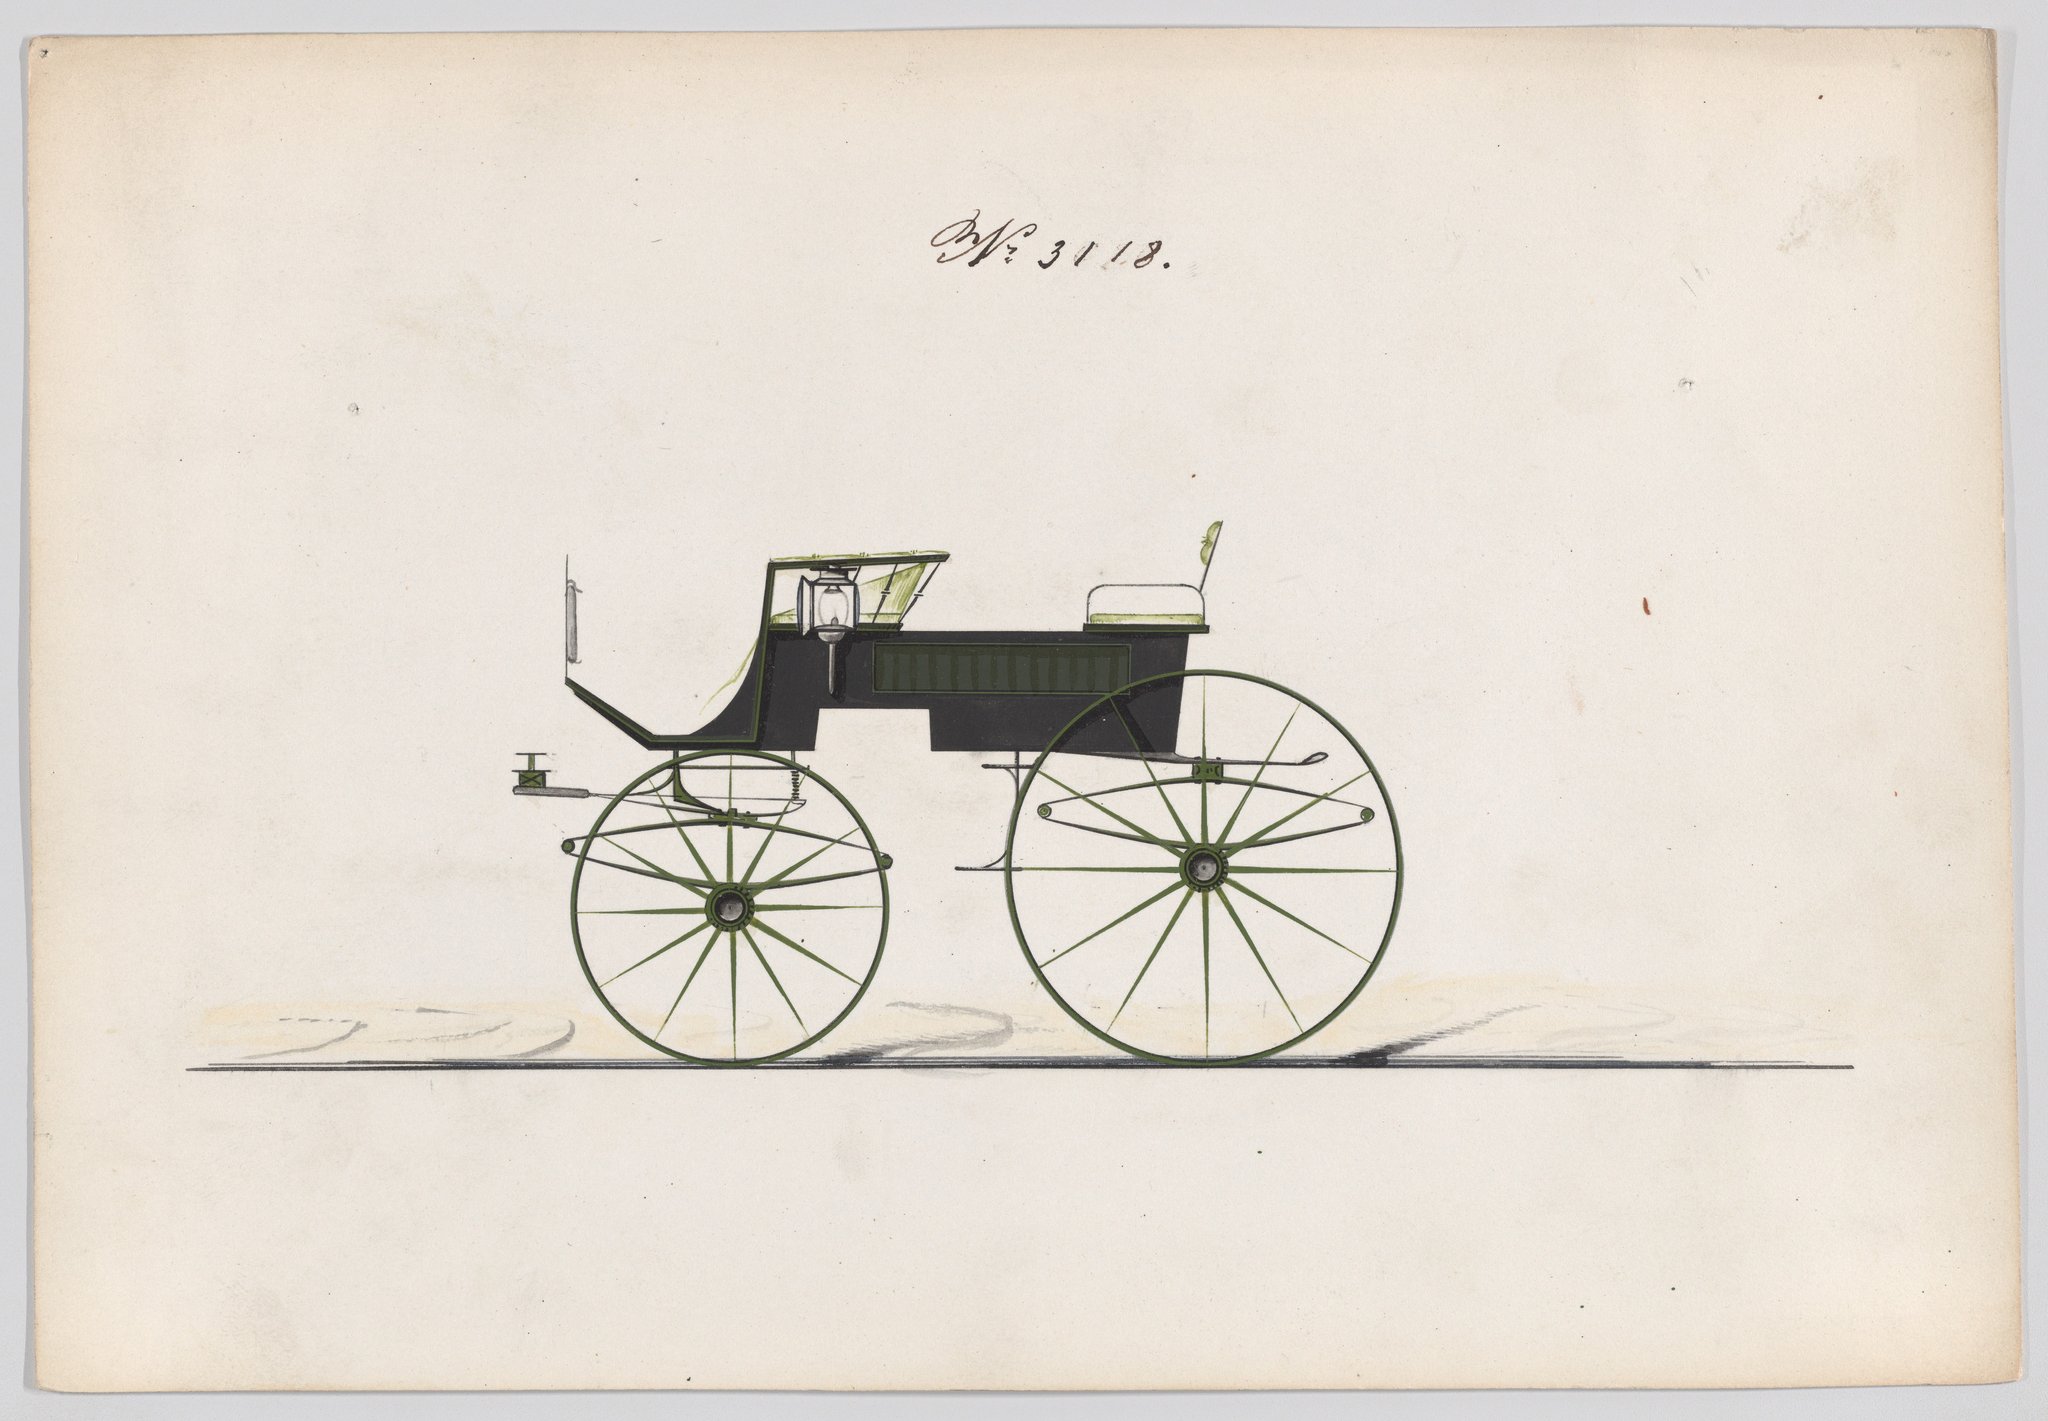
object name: drawing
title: Design for T-Cart, no. 3118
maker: brewster & co.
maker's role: manufacturer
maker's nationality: american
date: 1875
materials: gouache, gum arabic, ink, watercolor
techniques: pen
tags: carriages